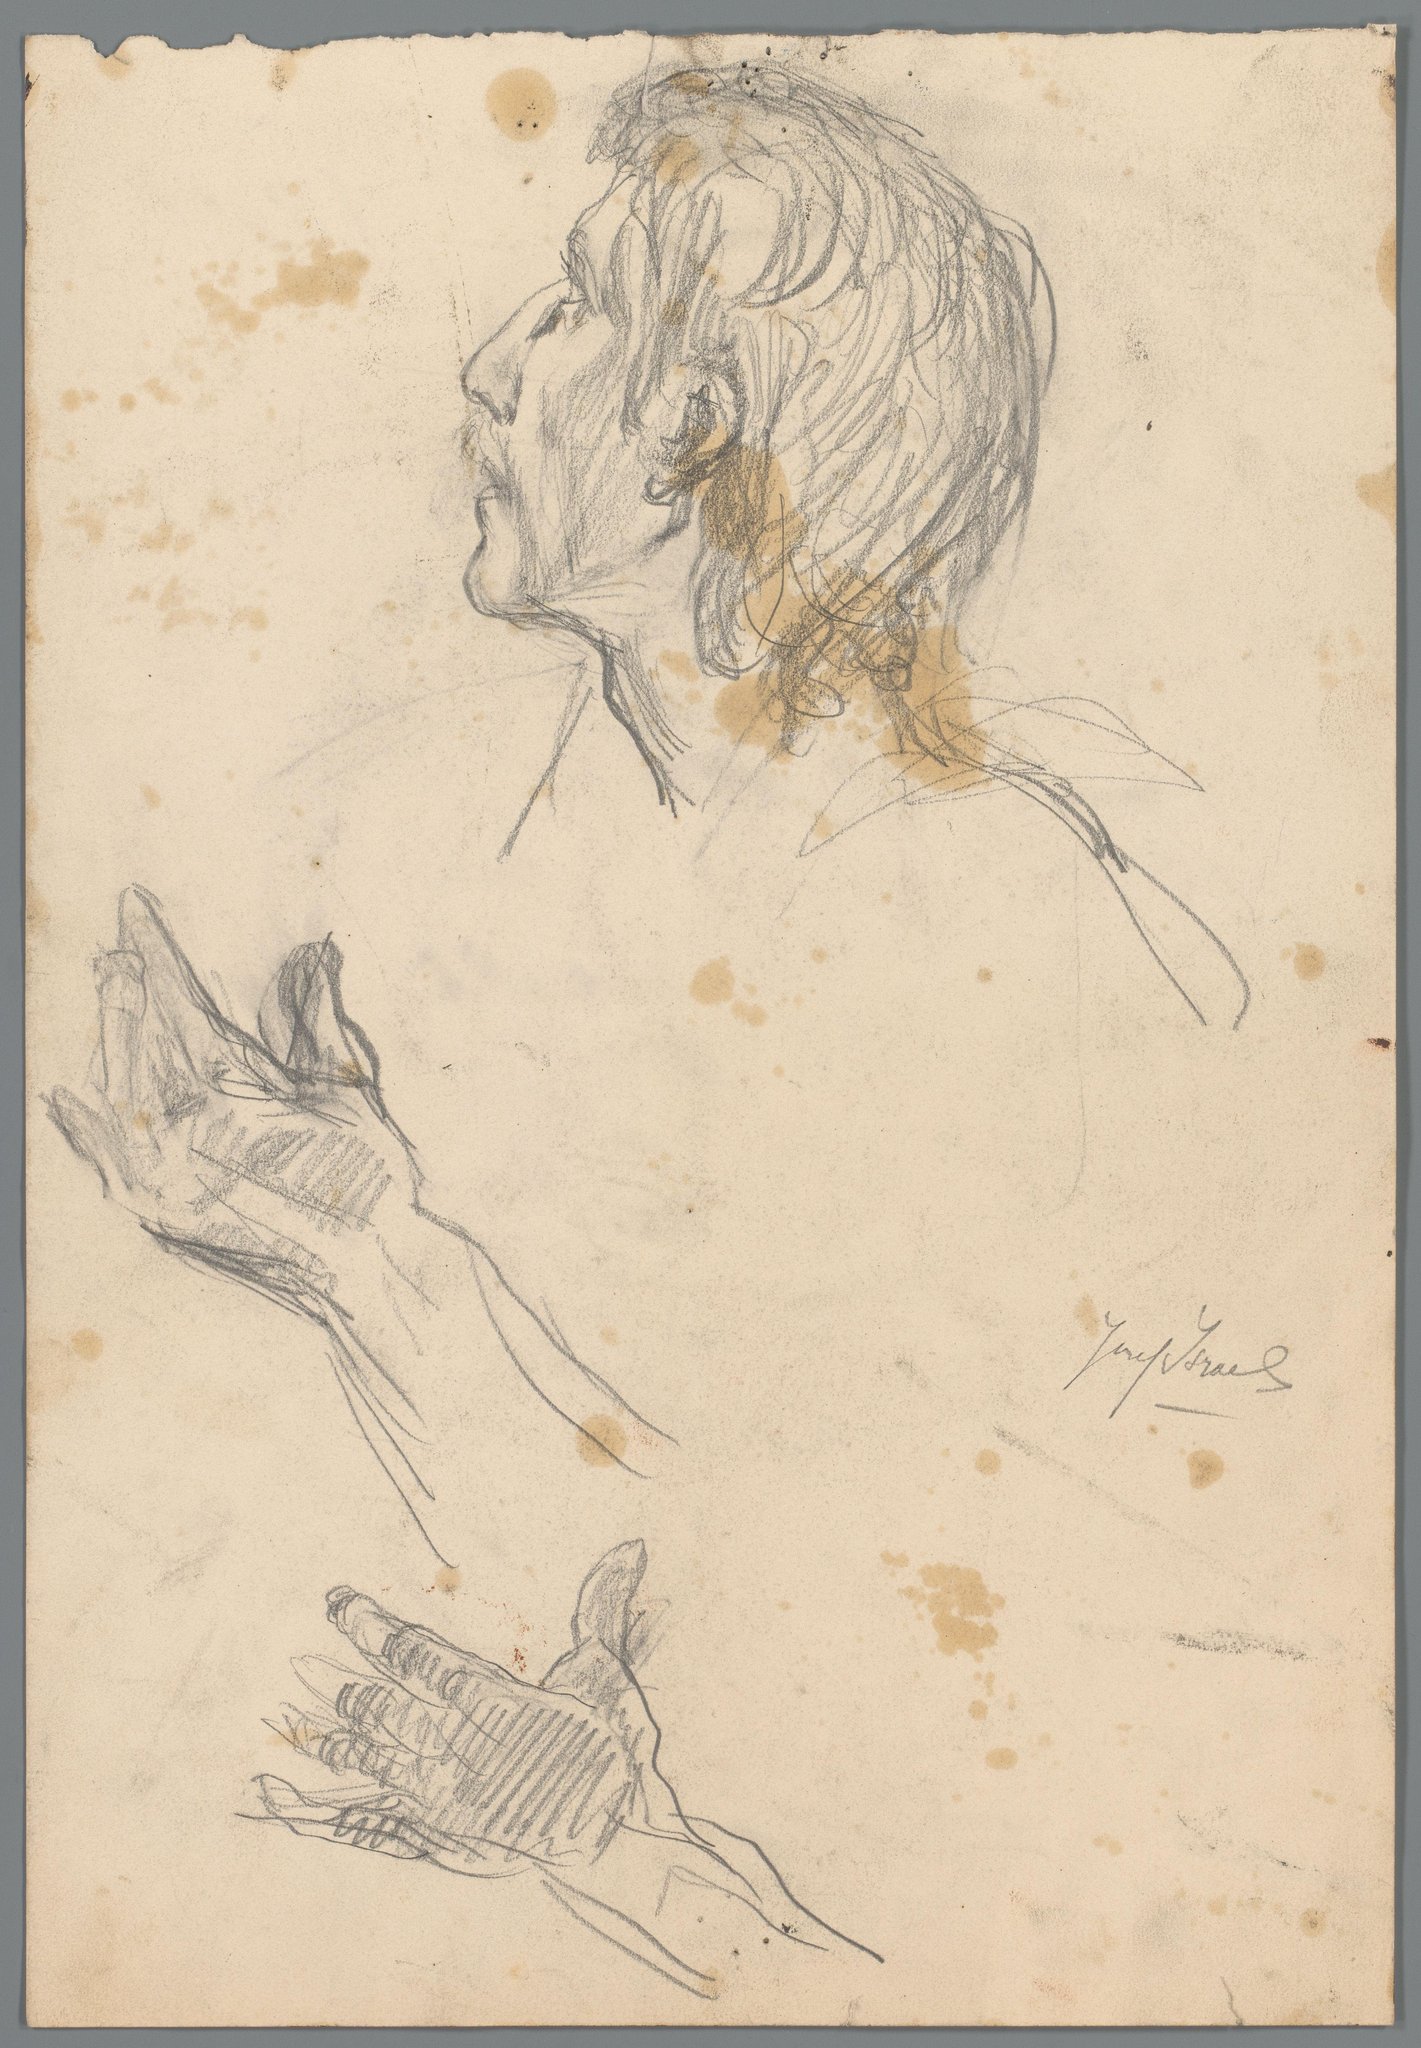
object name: drawing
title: Hoofd en handen van David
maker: jozef israëls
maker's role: draughtsman, painter, print maker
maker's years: 1824-1911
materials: paper, pencil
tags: david as musician, usually playing the harp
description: Voorstudie voor het schilderij 'David en Saul' dat zich in het Groninger Museum bevindt.